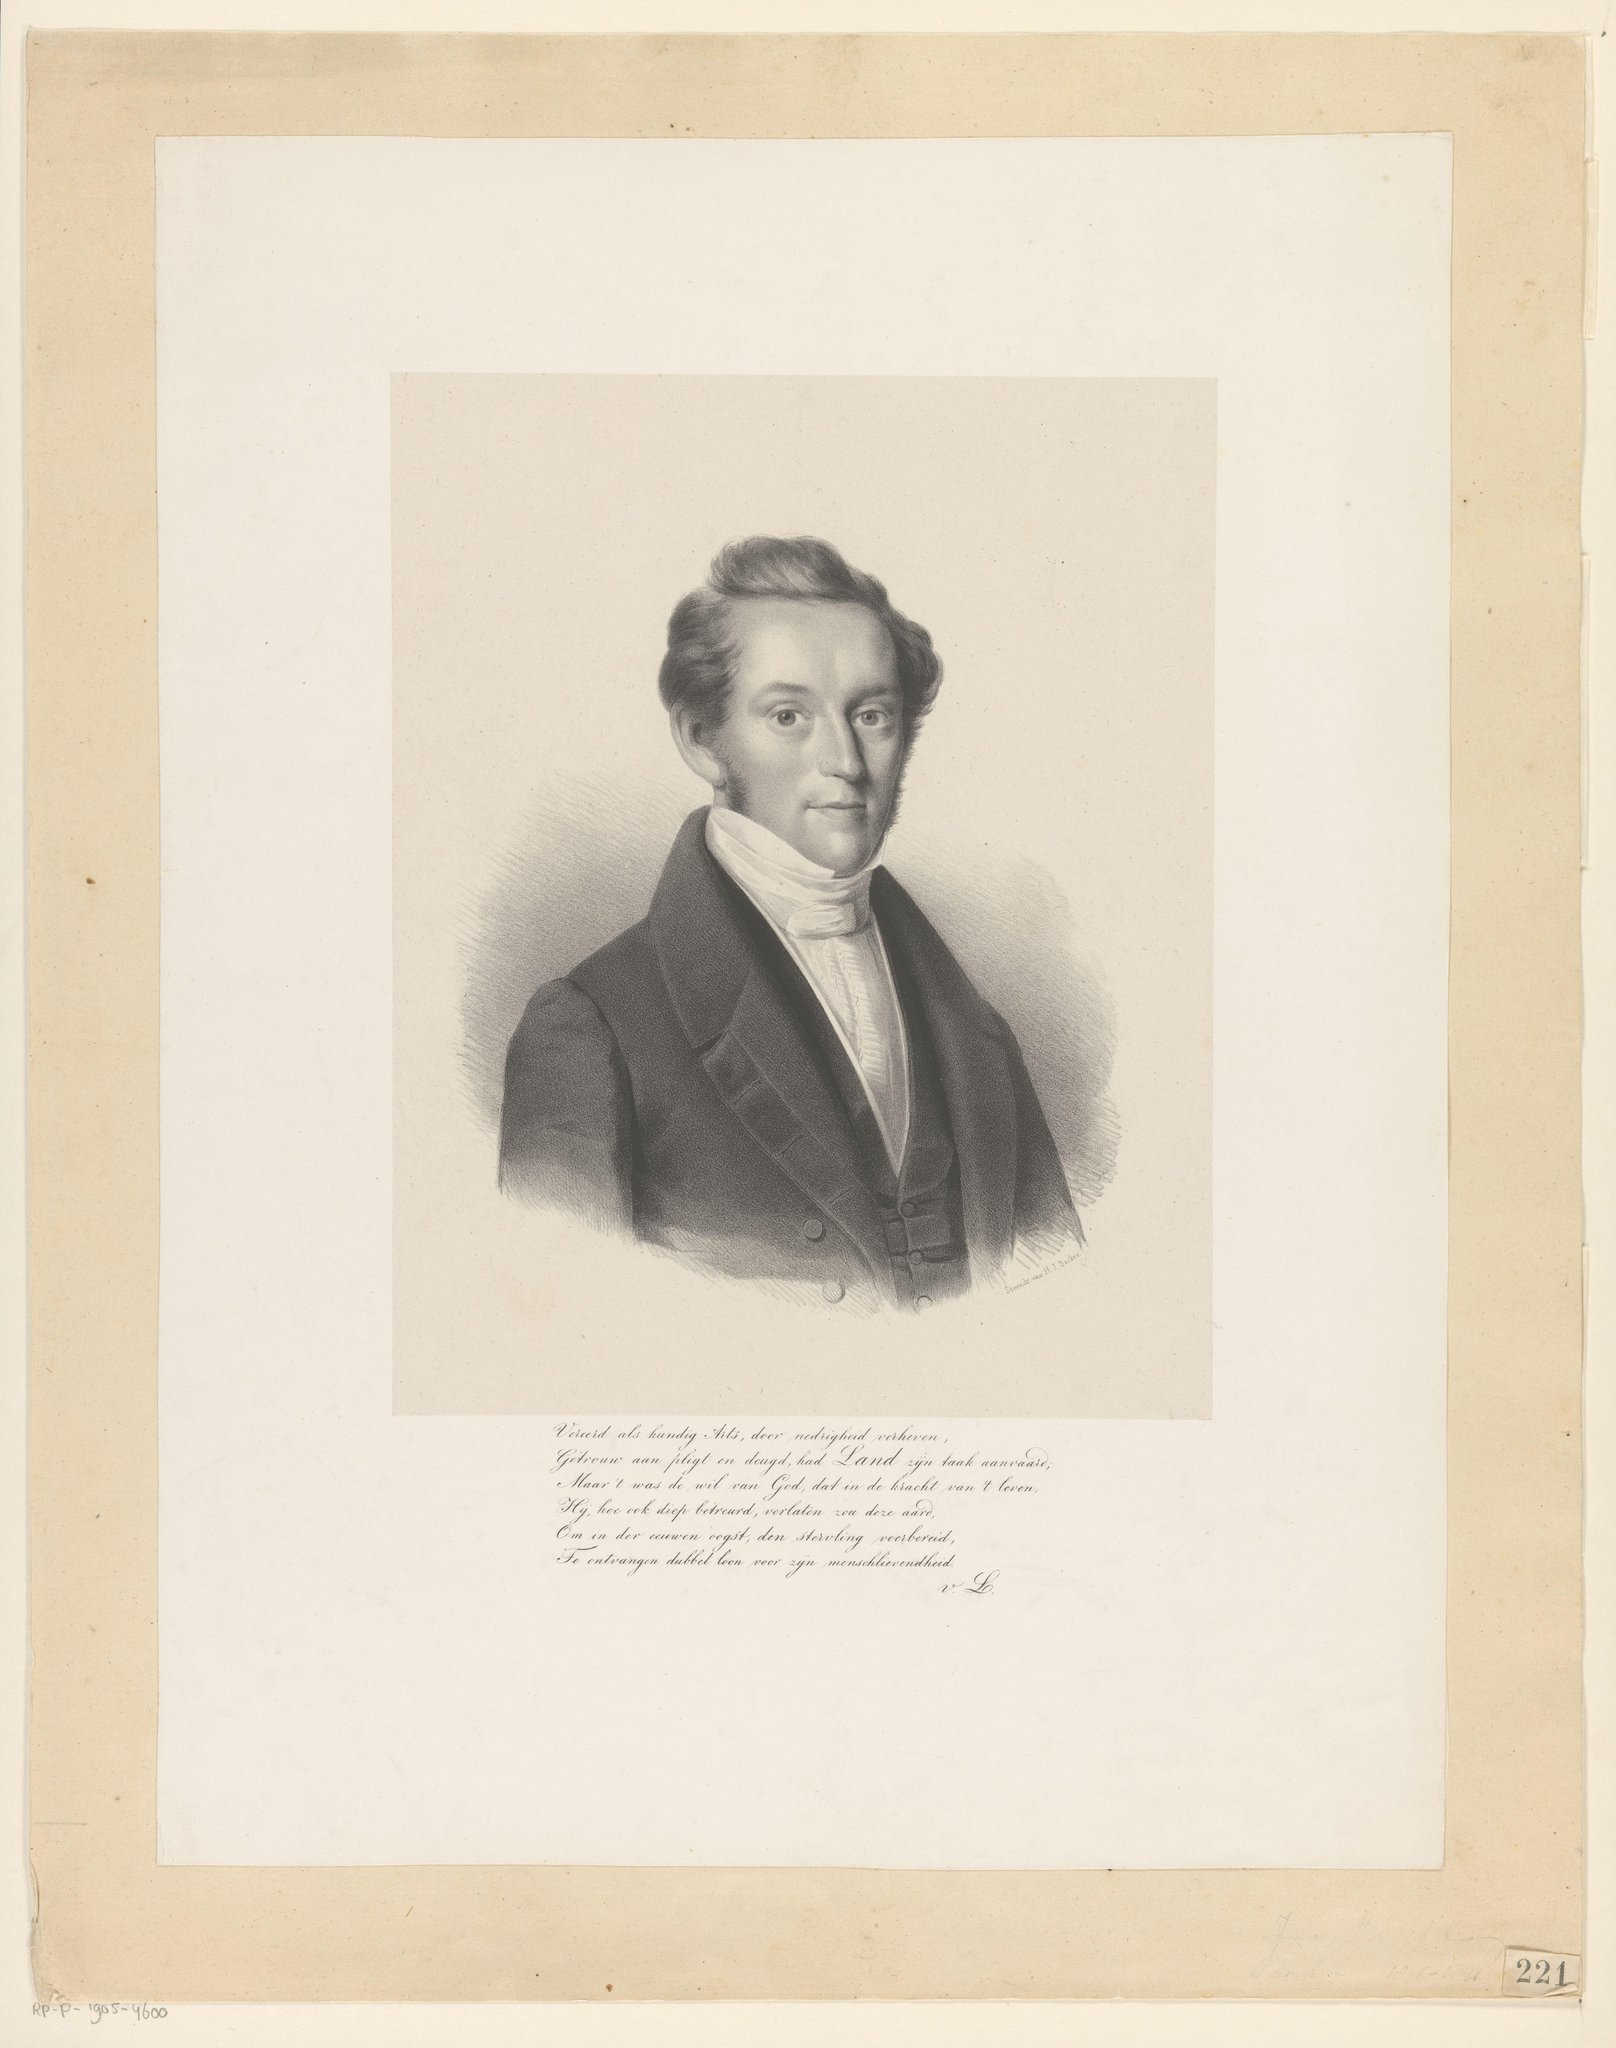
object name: print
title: Portret van Axel Lourents Land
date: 1822-1845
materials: paper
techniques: lithograph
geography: dordrecht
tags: historical persons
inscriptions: collector's mark: Lugt 2228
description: Aan deze tweede staat zijn de drukker en enkele dichtregels toegevoegd.